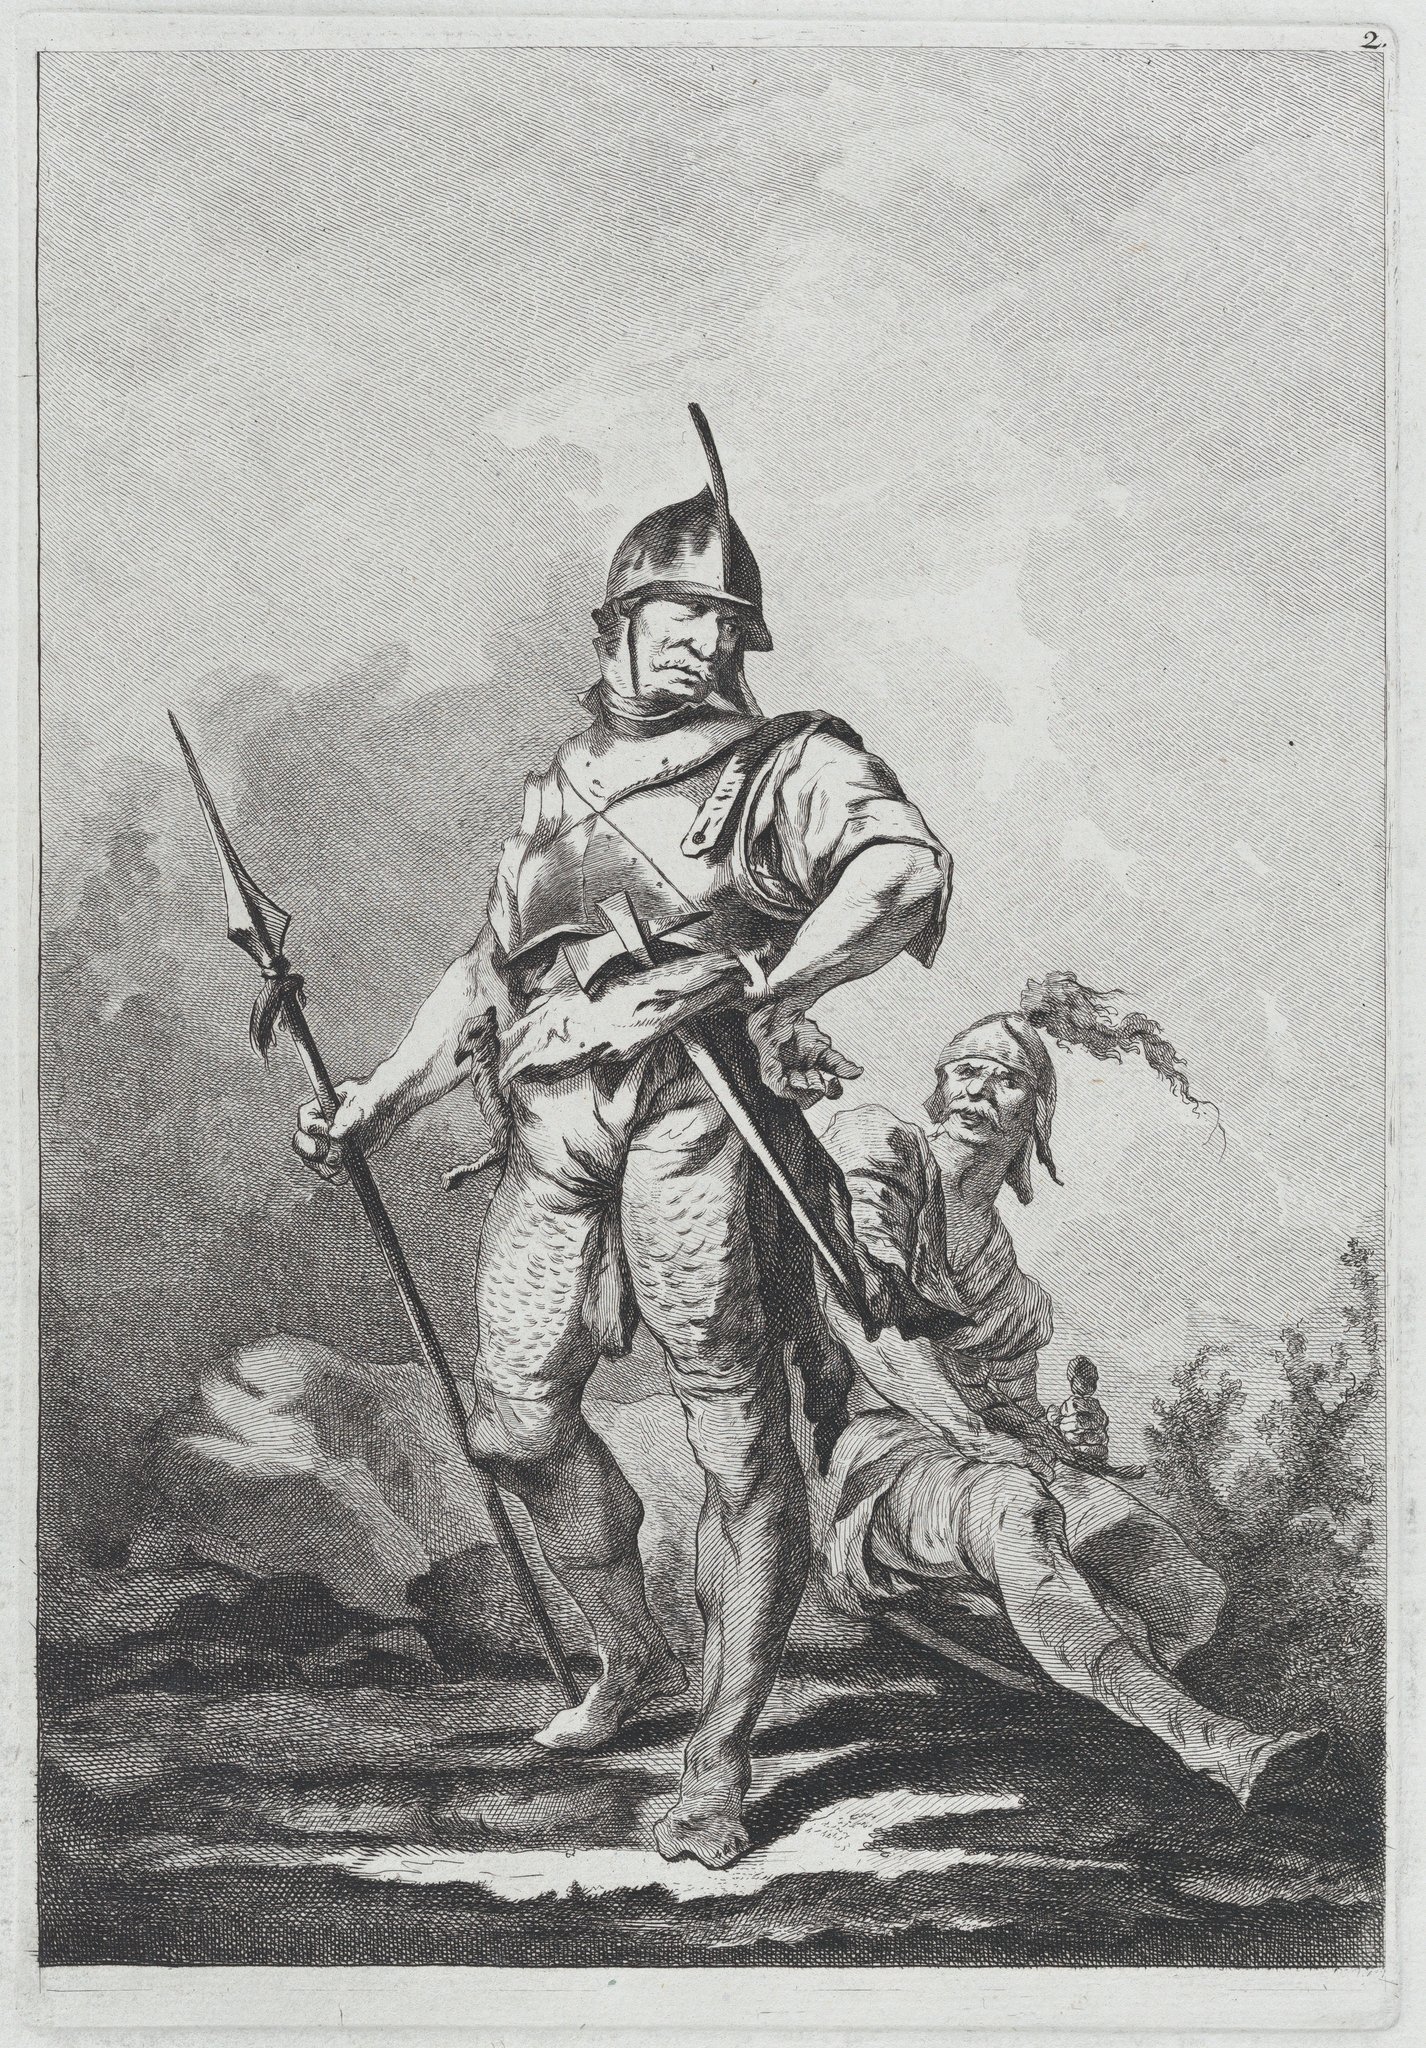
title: Two Soldiers, One Standing Holding a Lance, One Seated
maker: matthias pfenninger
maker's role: etcher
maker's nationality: swiss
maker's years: 1739-1813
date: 1764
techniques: etching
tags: soldiers,men